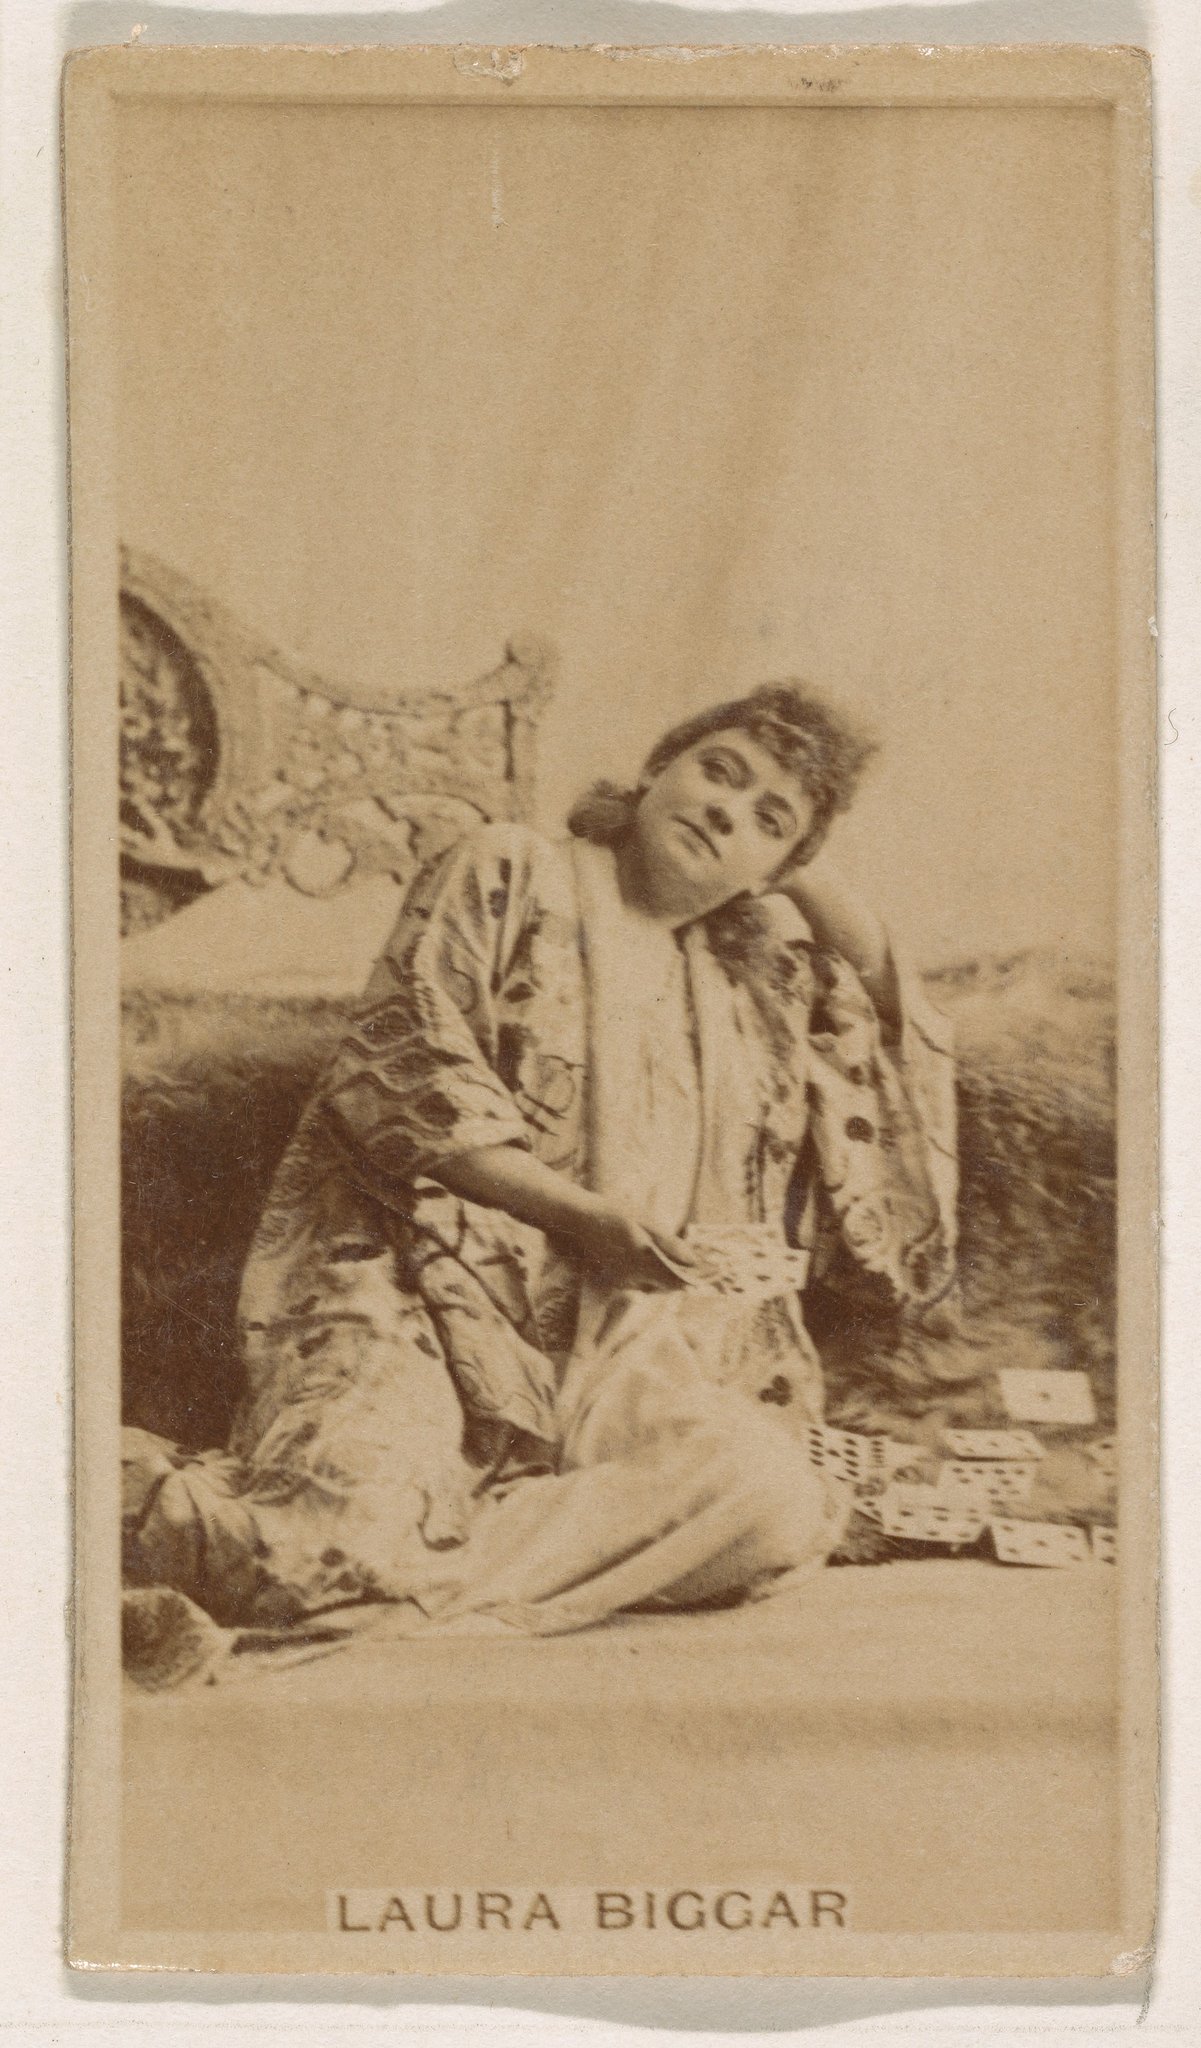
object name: photograph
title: Laura Biggar, from the Actresses series (N245) issued by Kinney Brothers to promote Sweet Caporal Cigarettes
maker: kinney brothers tobacco company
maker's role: publisher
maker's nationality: american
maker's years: 1869-2011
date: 1890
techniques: albumen silver print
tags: portraits,women,actresses